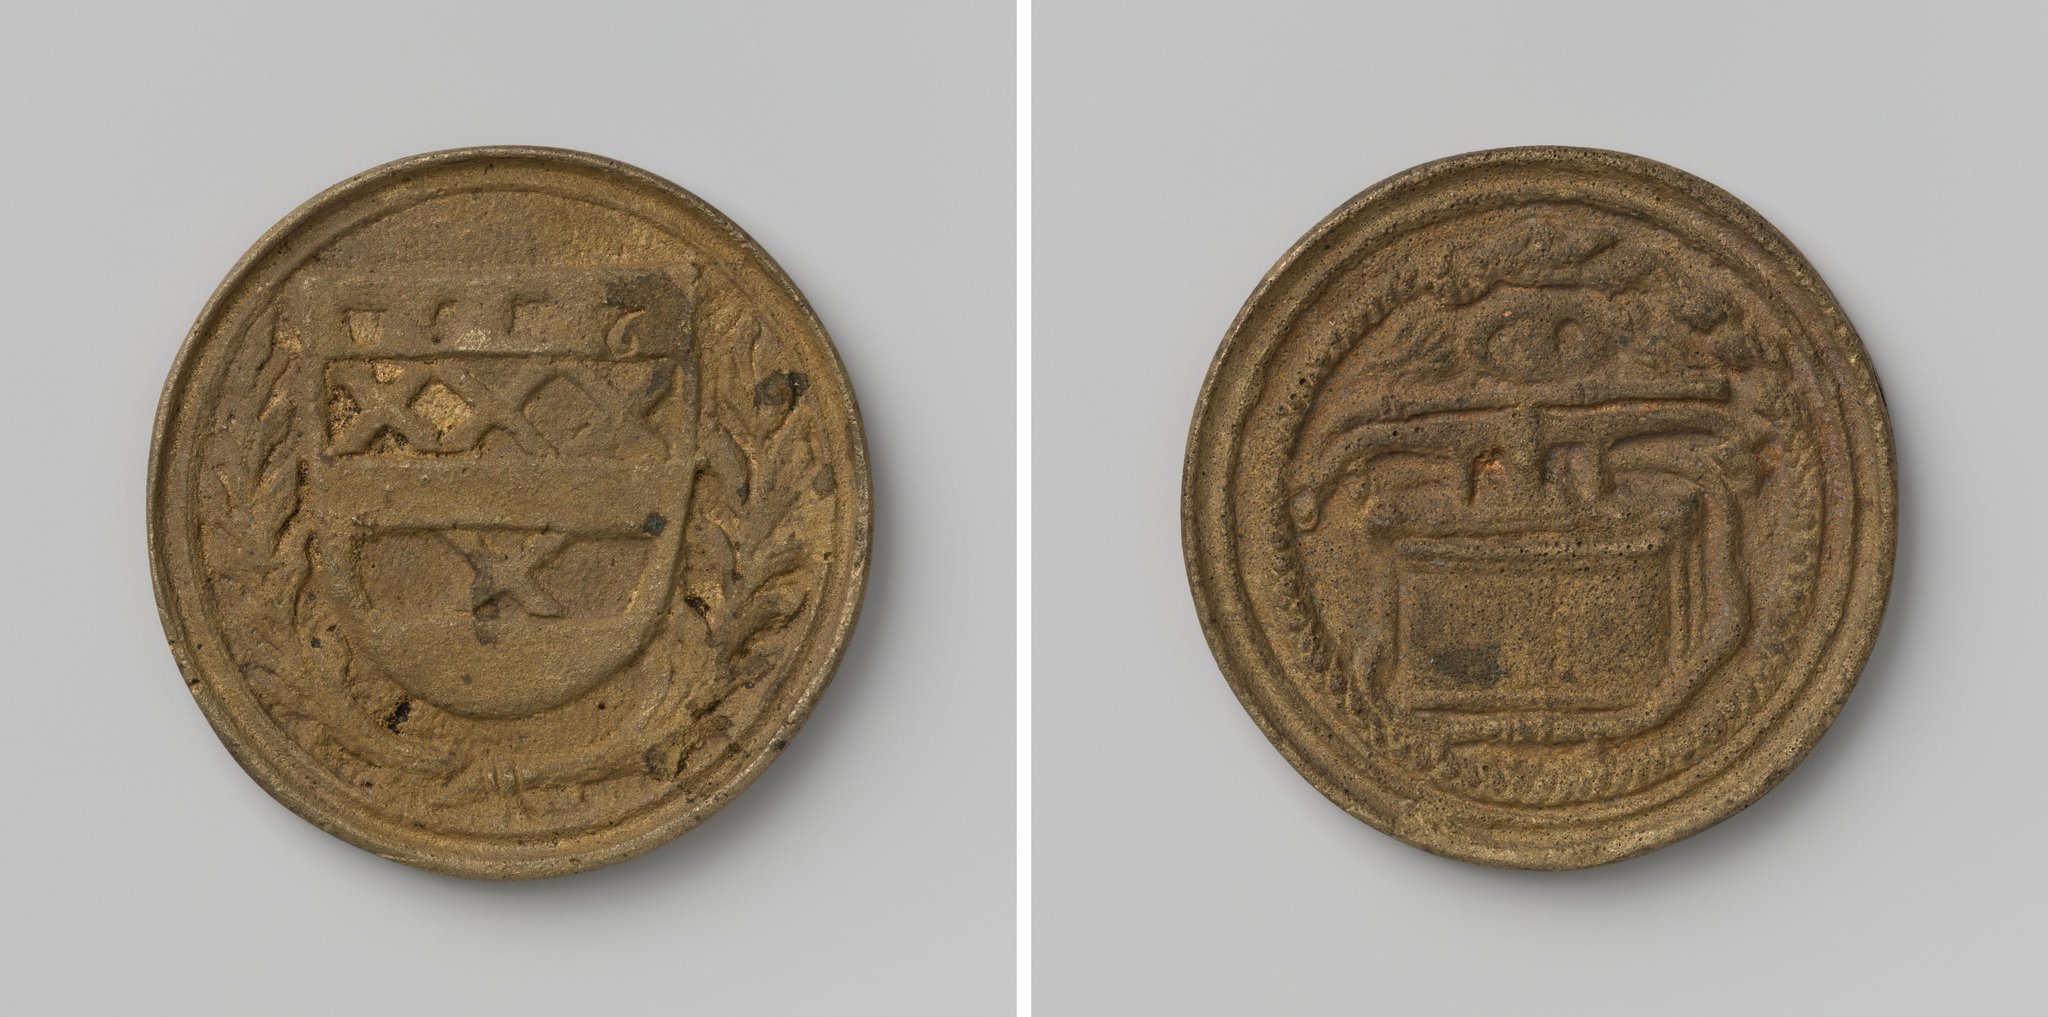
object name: fire engine medal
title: Nieuwer Amstel, brandspuitpenning met no. 61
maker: Anonymous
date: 1680-1800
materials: brass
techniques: casting, engraving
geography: amsterdam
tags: nieuwer-amstel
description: Messing penning. Voorzijde: wapenschild binnen bladertakken; op bovenste balk van wapenschild: opschrift W 5 N 6. Keerzijde: brandspuit onder cartouche met cijfer 61 binnen slangerond